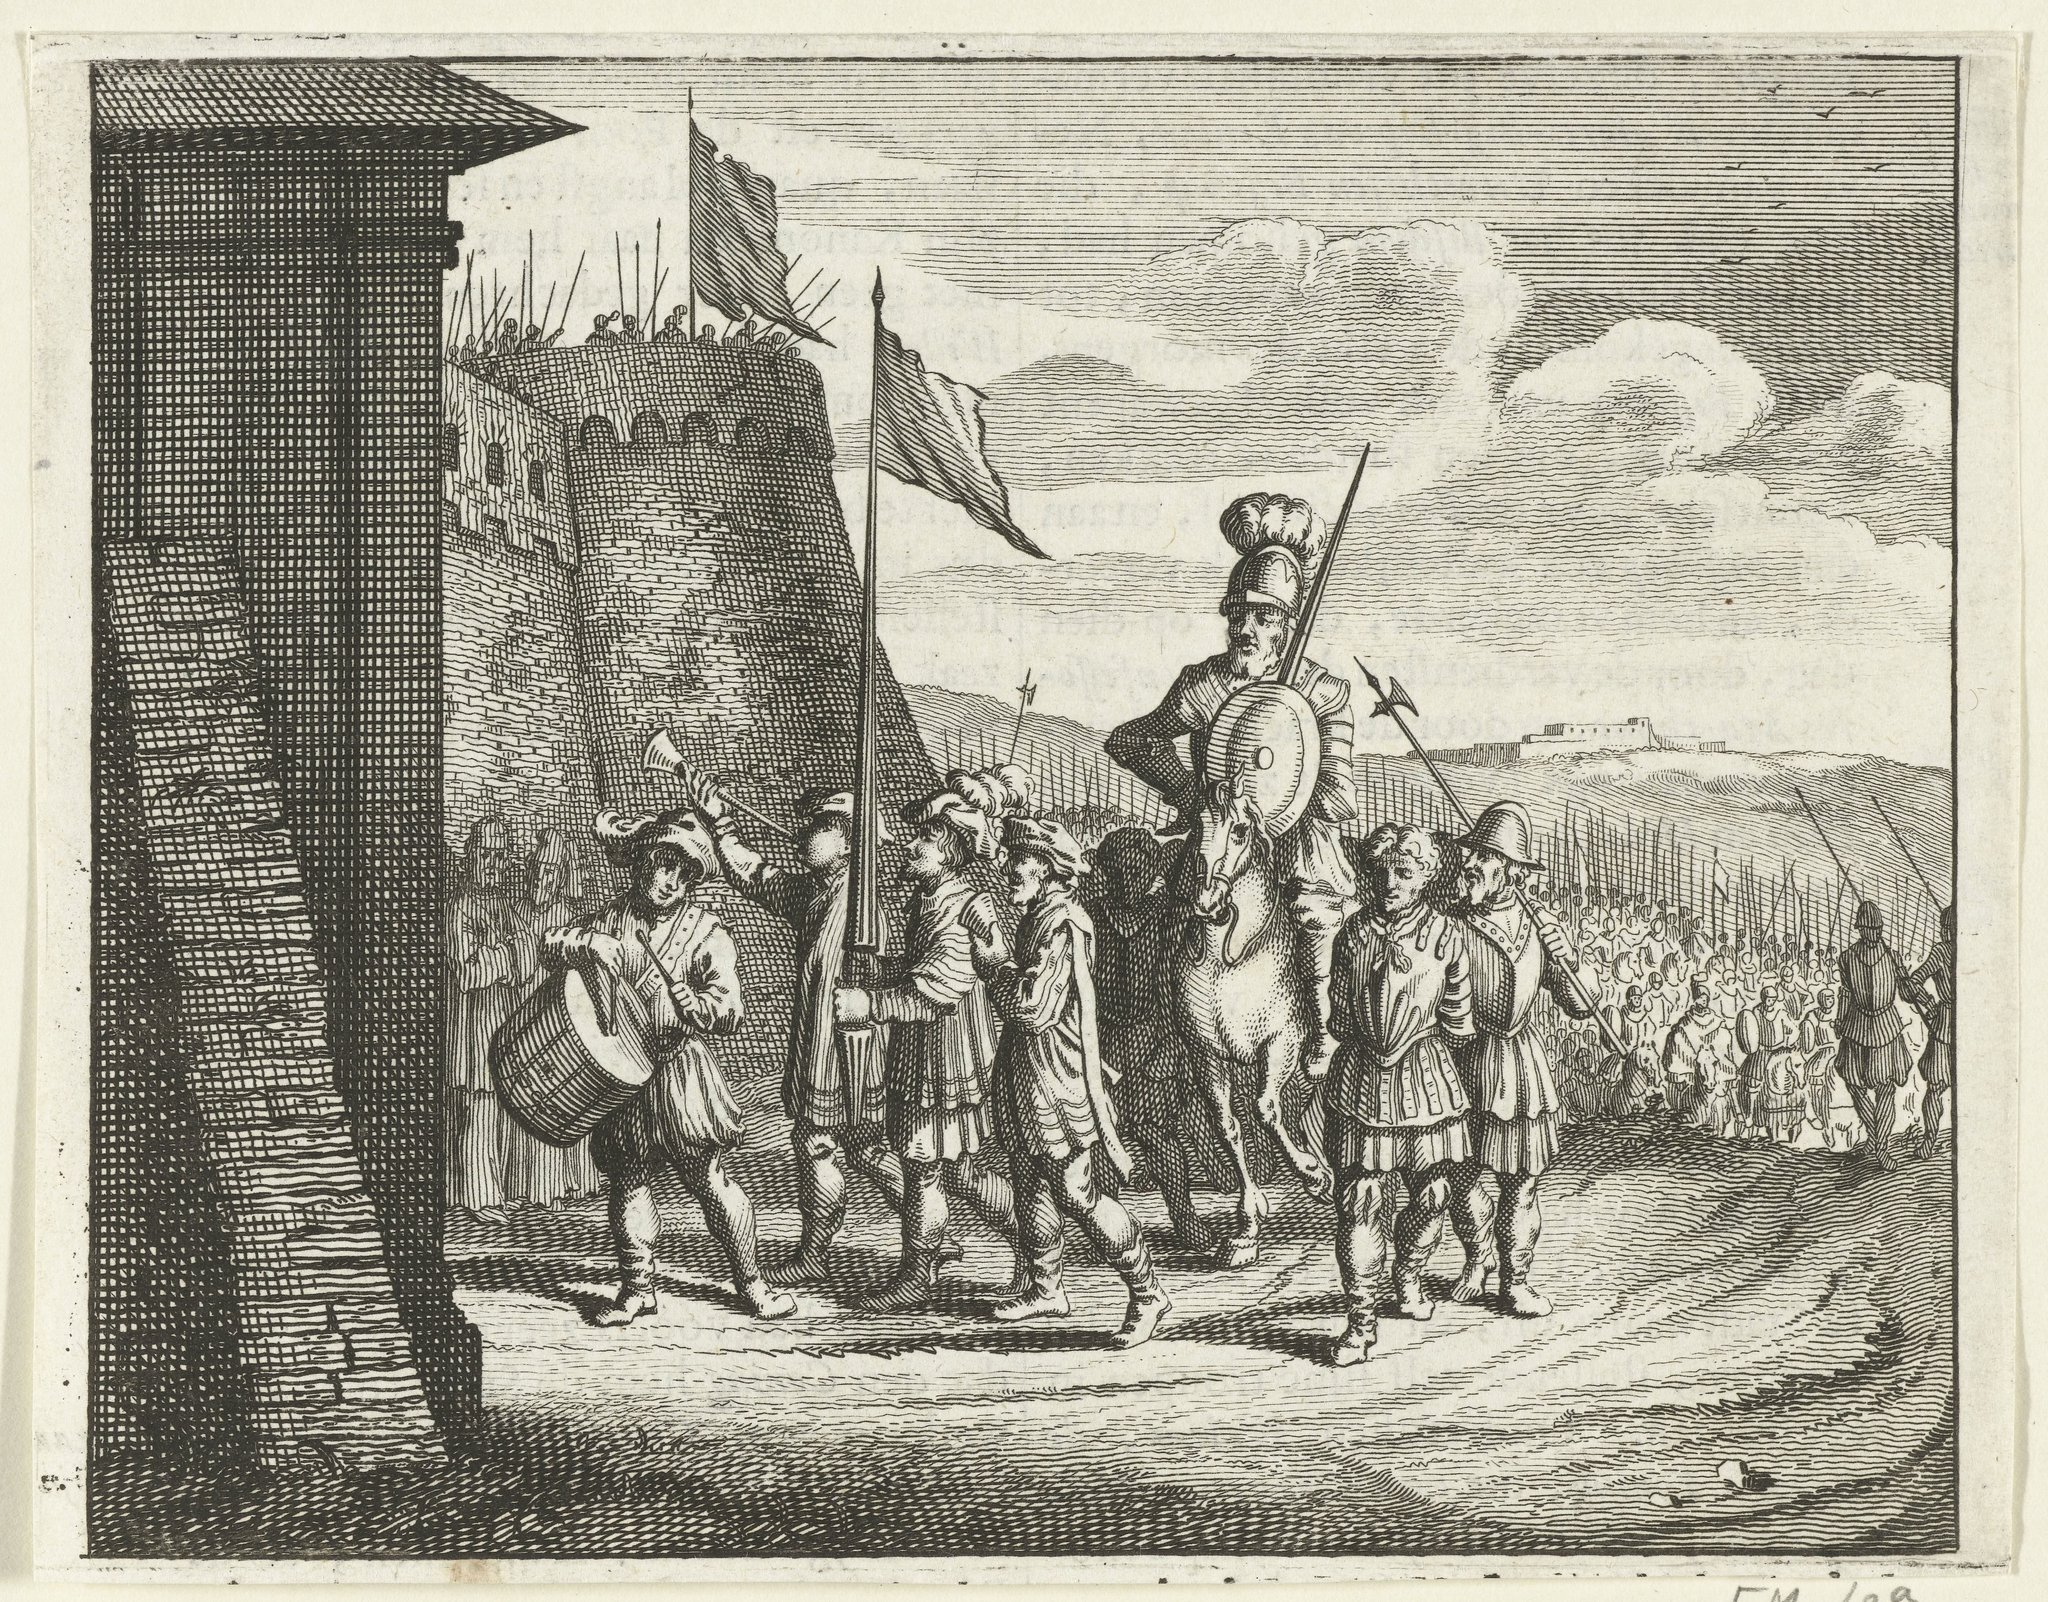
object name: history print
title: Gijsbrecht van Amstel en Herman van Woerden als gevangenen Utrecht binnengeleid, 1252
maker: Anonymous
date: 1662-1664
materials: paper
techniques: etching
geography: northern netherlands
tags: hendrik i van vianden, utrecht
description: Gijsbrecht van Amstel en Herman van Woerden geslagen en als gevangenen van Hendrik I van Vianden, bisschop van Utrecht, Utrecht binnengeleid, 16 juni 1252. Een stoet soldaten arriveert bij een stadspoort.